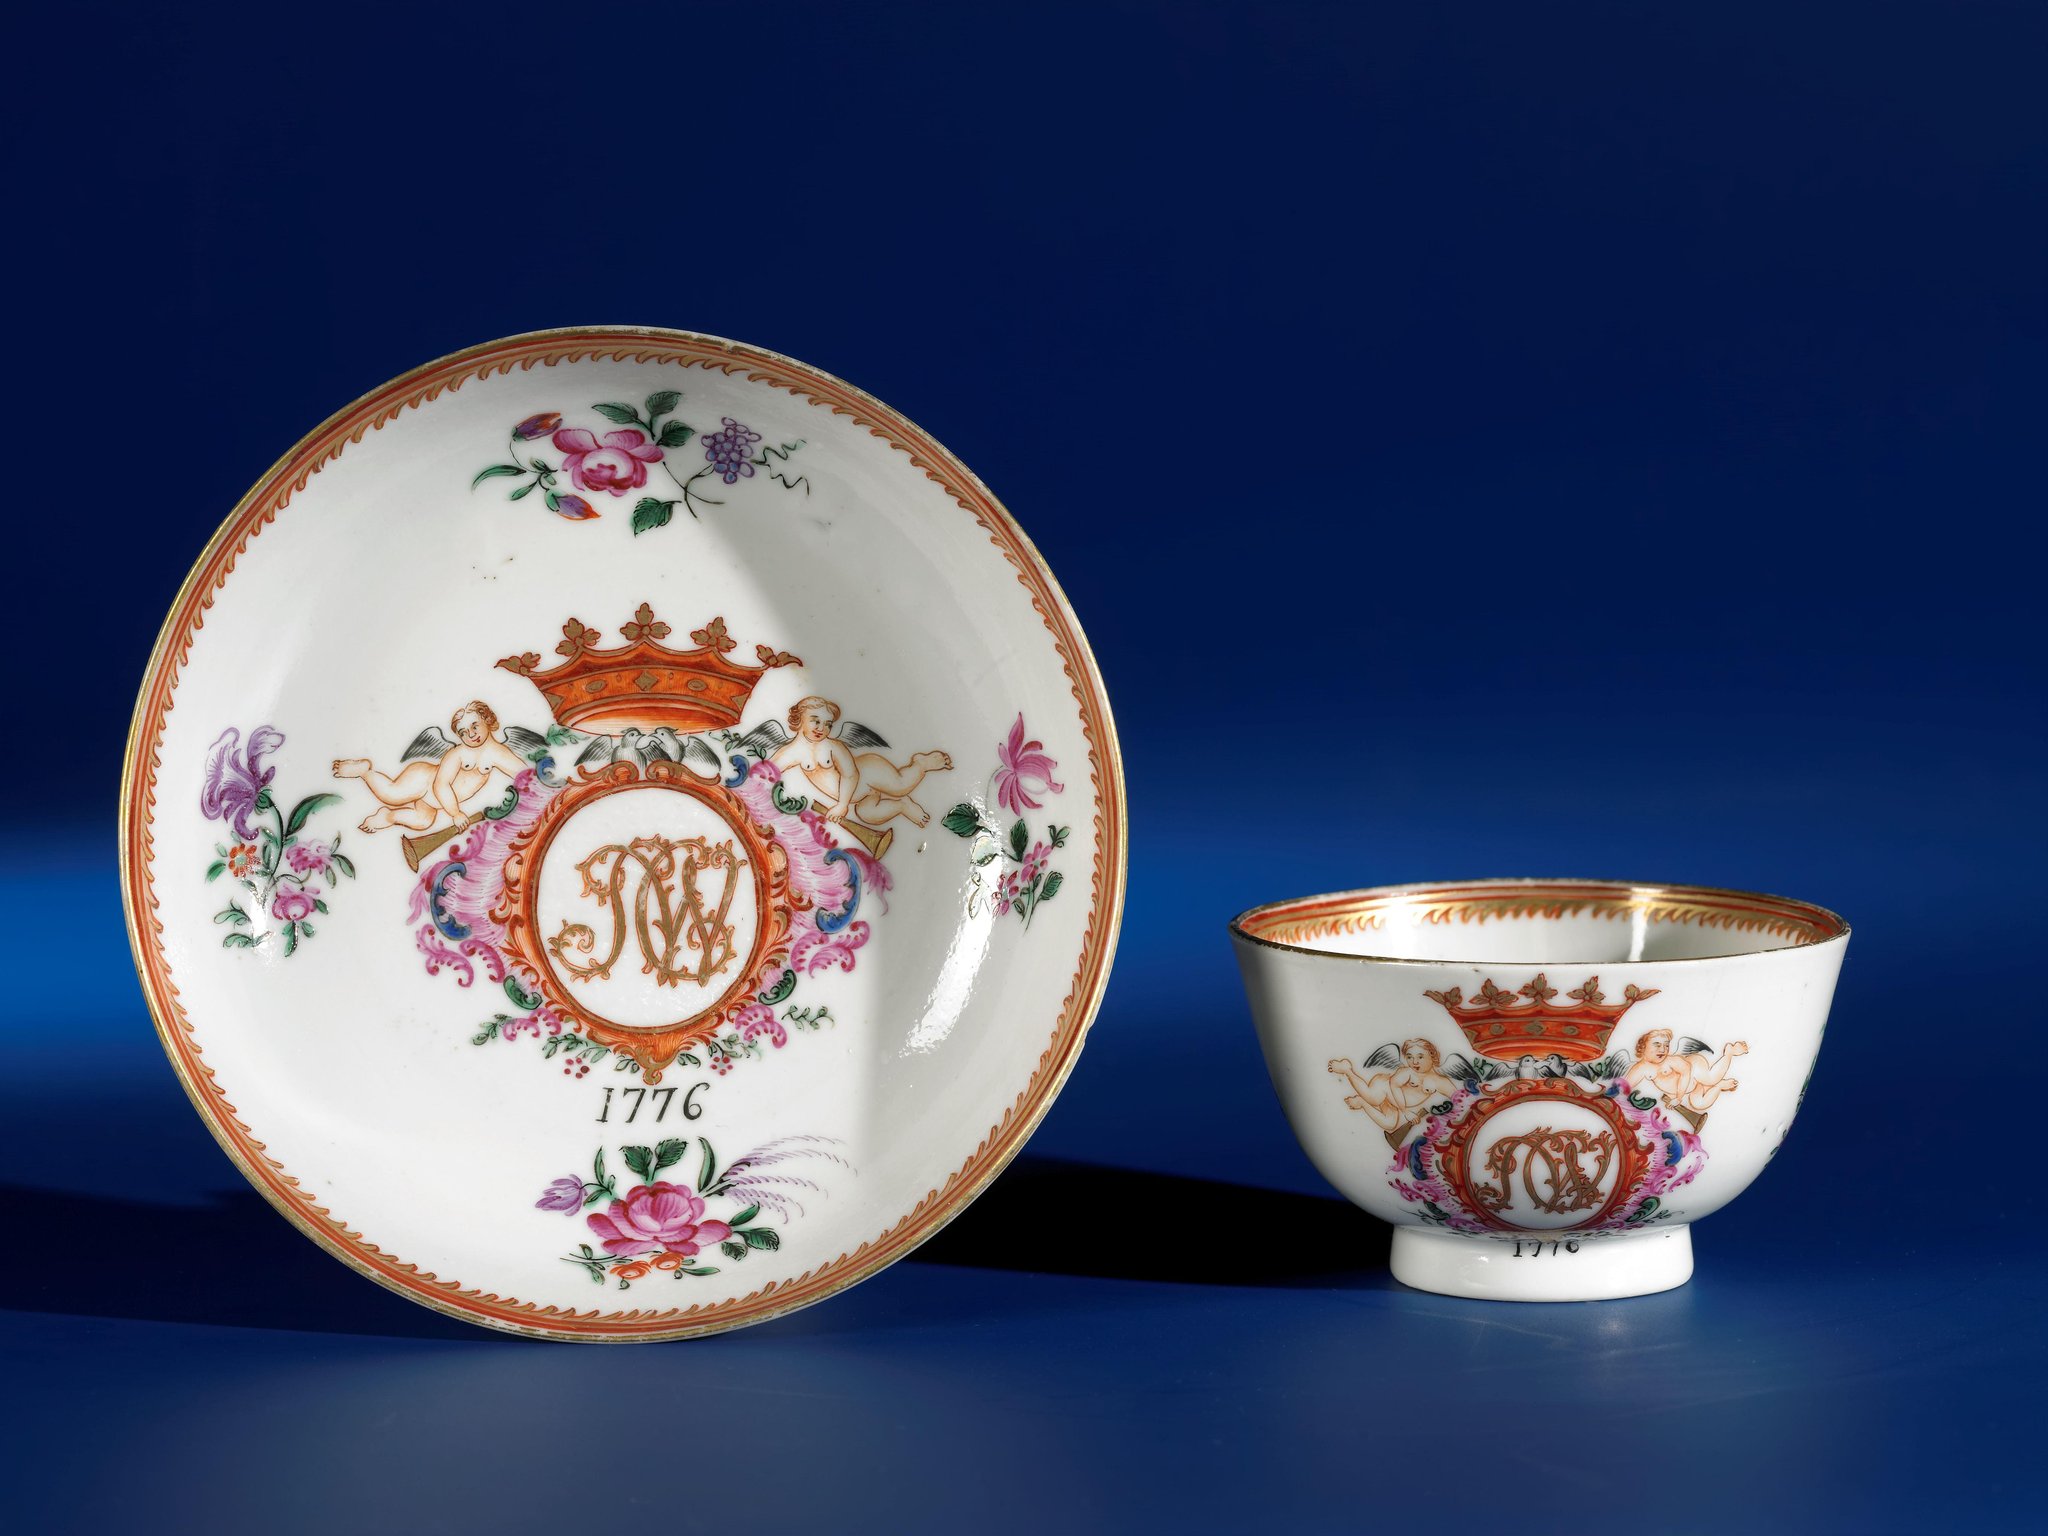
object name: kop en schotel, kop en schotel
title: Saucer with a crowned monogram and flower sprays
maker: Anonymous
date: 1776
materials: glaze, gold, paint, porcelain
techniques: firing, gilding, turning, vitrification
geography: china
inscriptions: label: ‘S.C.W. (British Museum)’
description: Wijd uitlopende kop op een hoge voetring en een schotel op een voetring. Gedecoreerd in emailkleuren. Op de kop en schotel een monogram met de initialen JCW; het monogram wordt aan beide zijden vastgehouden door een engel. Onder het monogram het jaartal 1776, boven het monogram een kroon. Boven en onder, links en rechts een bloempluk. Aan de binnenkant van de kop een decoratief randje.